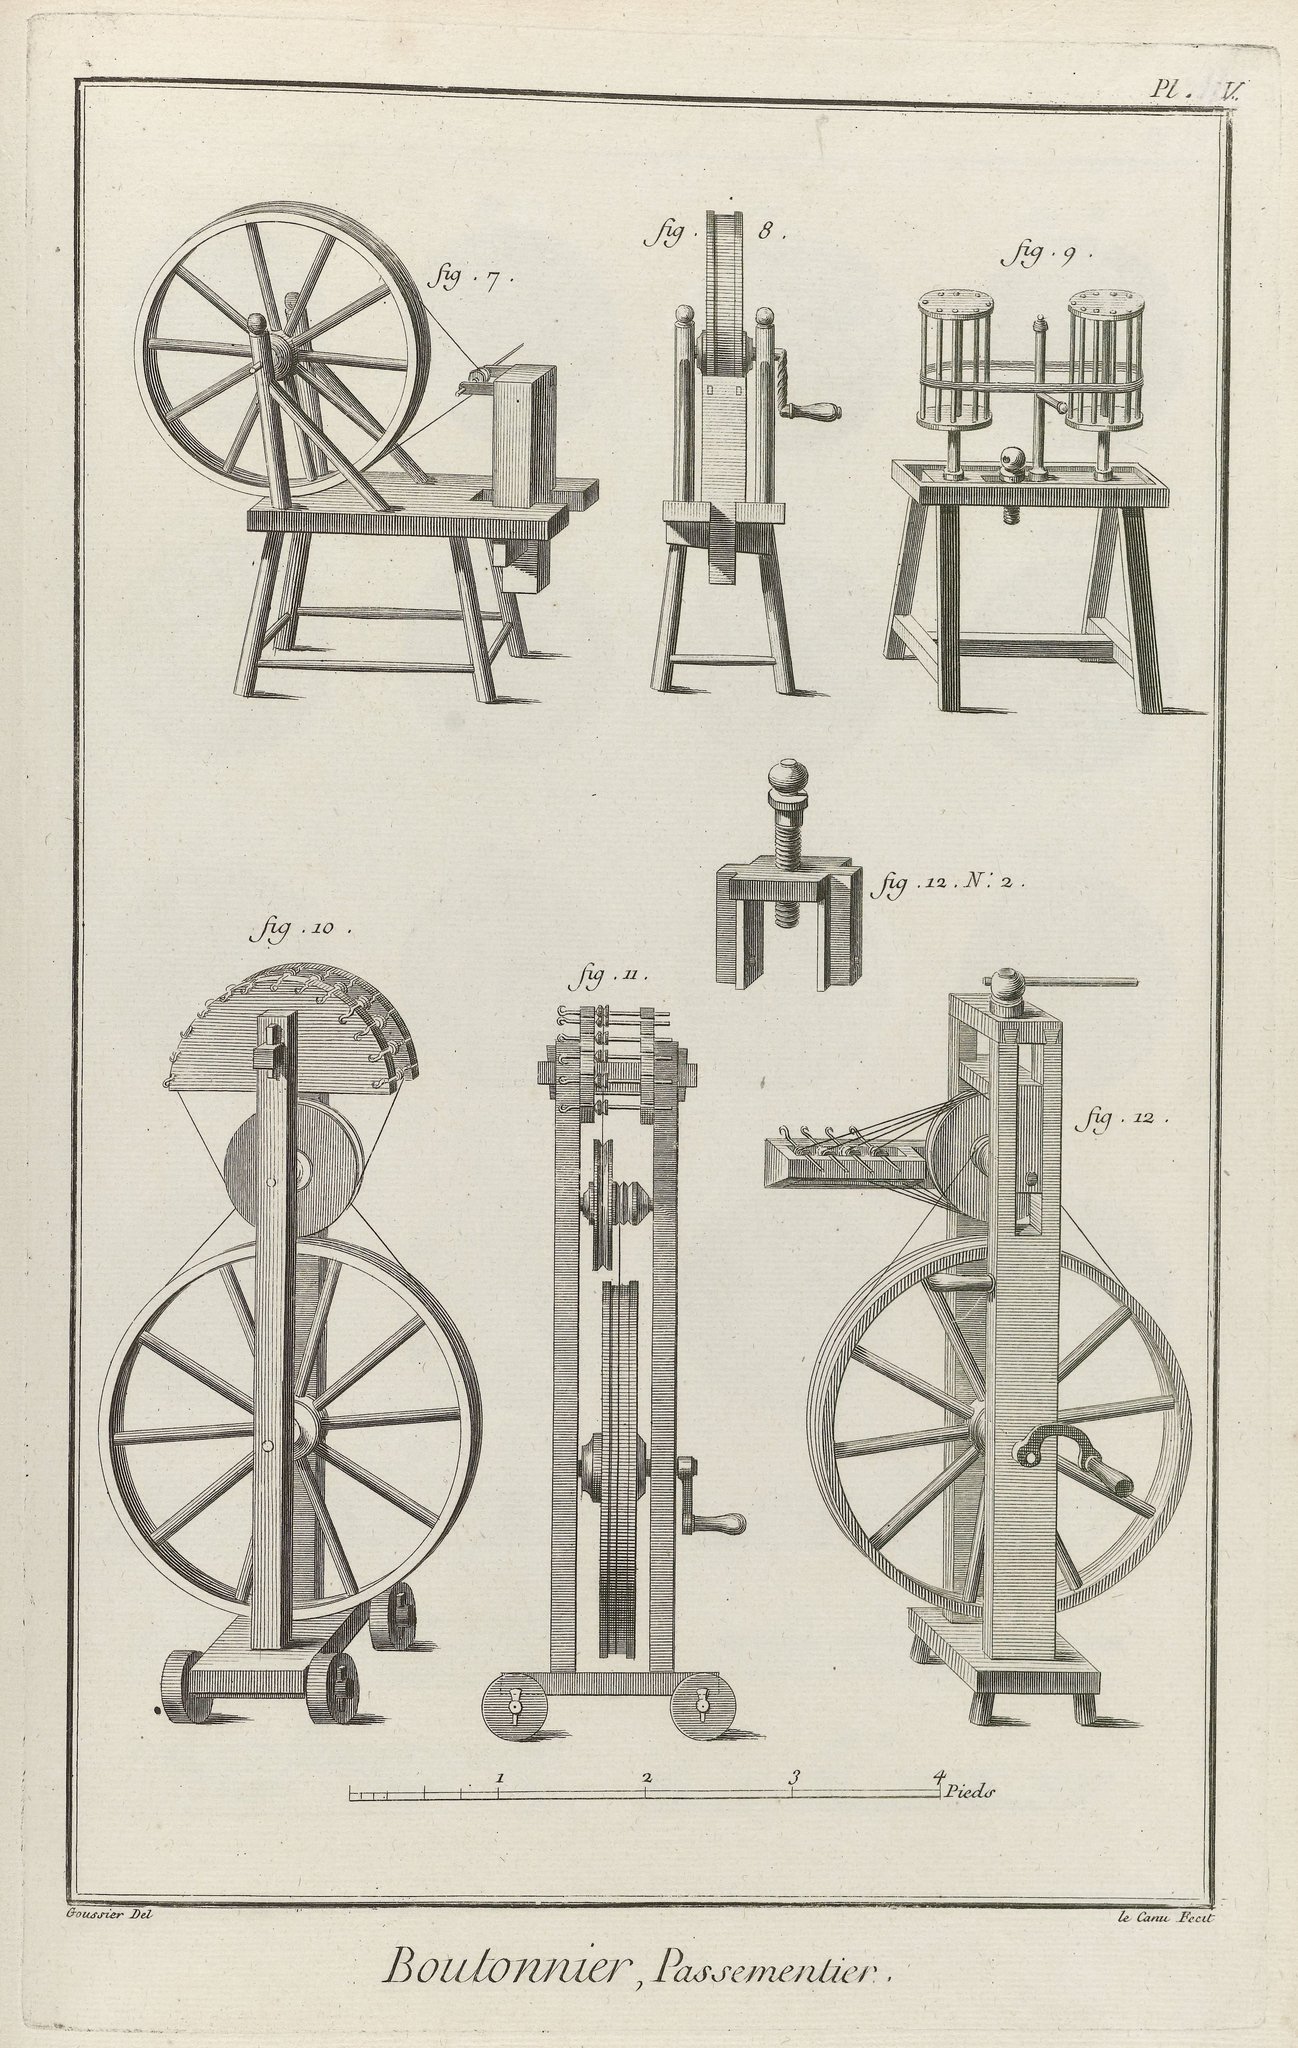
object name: book illustration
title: Boutonnier, Passementier.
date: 1751-1772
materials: paper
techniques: engraving, letterpress printing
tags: fashion plates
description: Over het maken van knopen en passementen: draaiwielen om garens te draaien. Uit Encyclopédie ou dictionnaire raisonné des sciences, des arts et des métiers door Denis Diderot en Jean Le Rond d'Alembert, Parijs, 1751-1772.